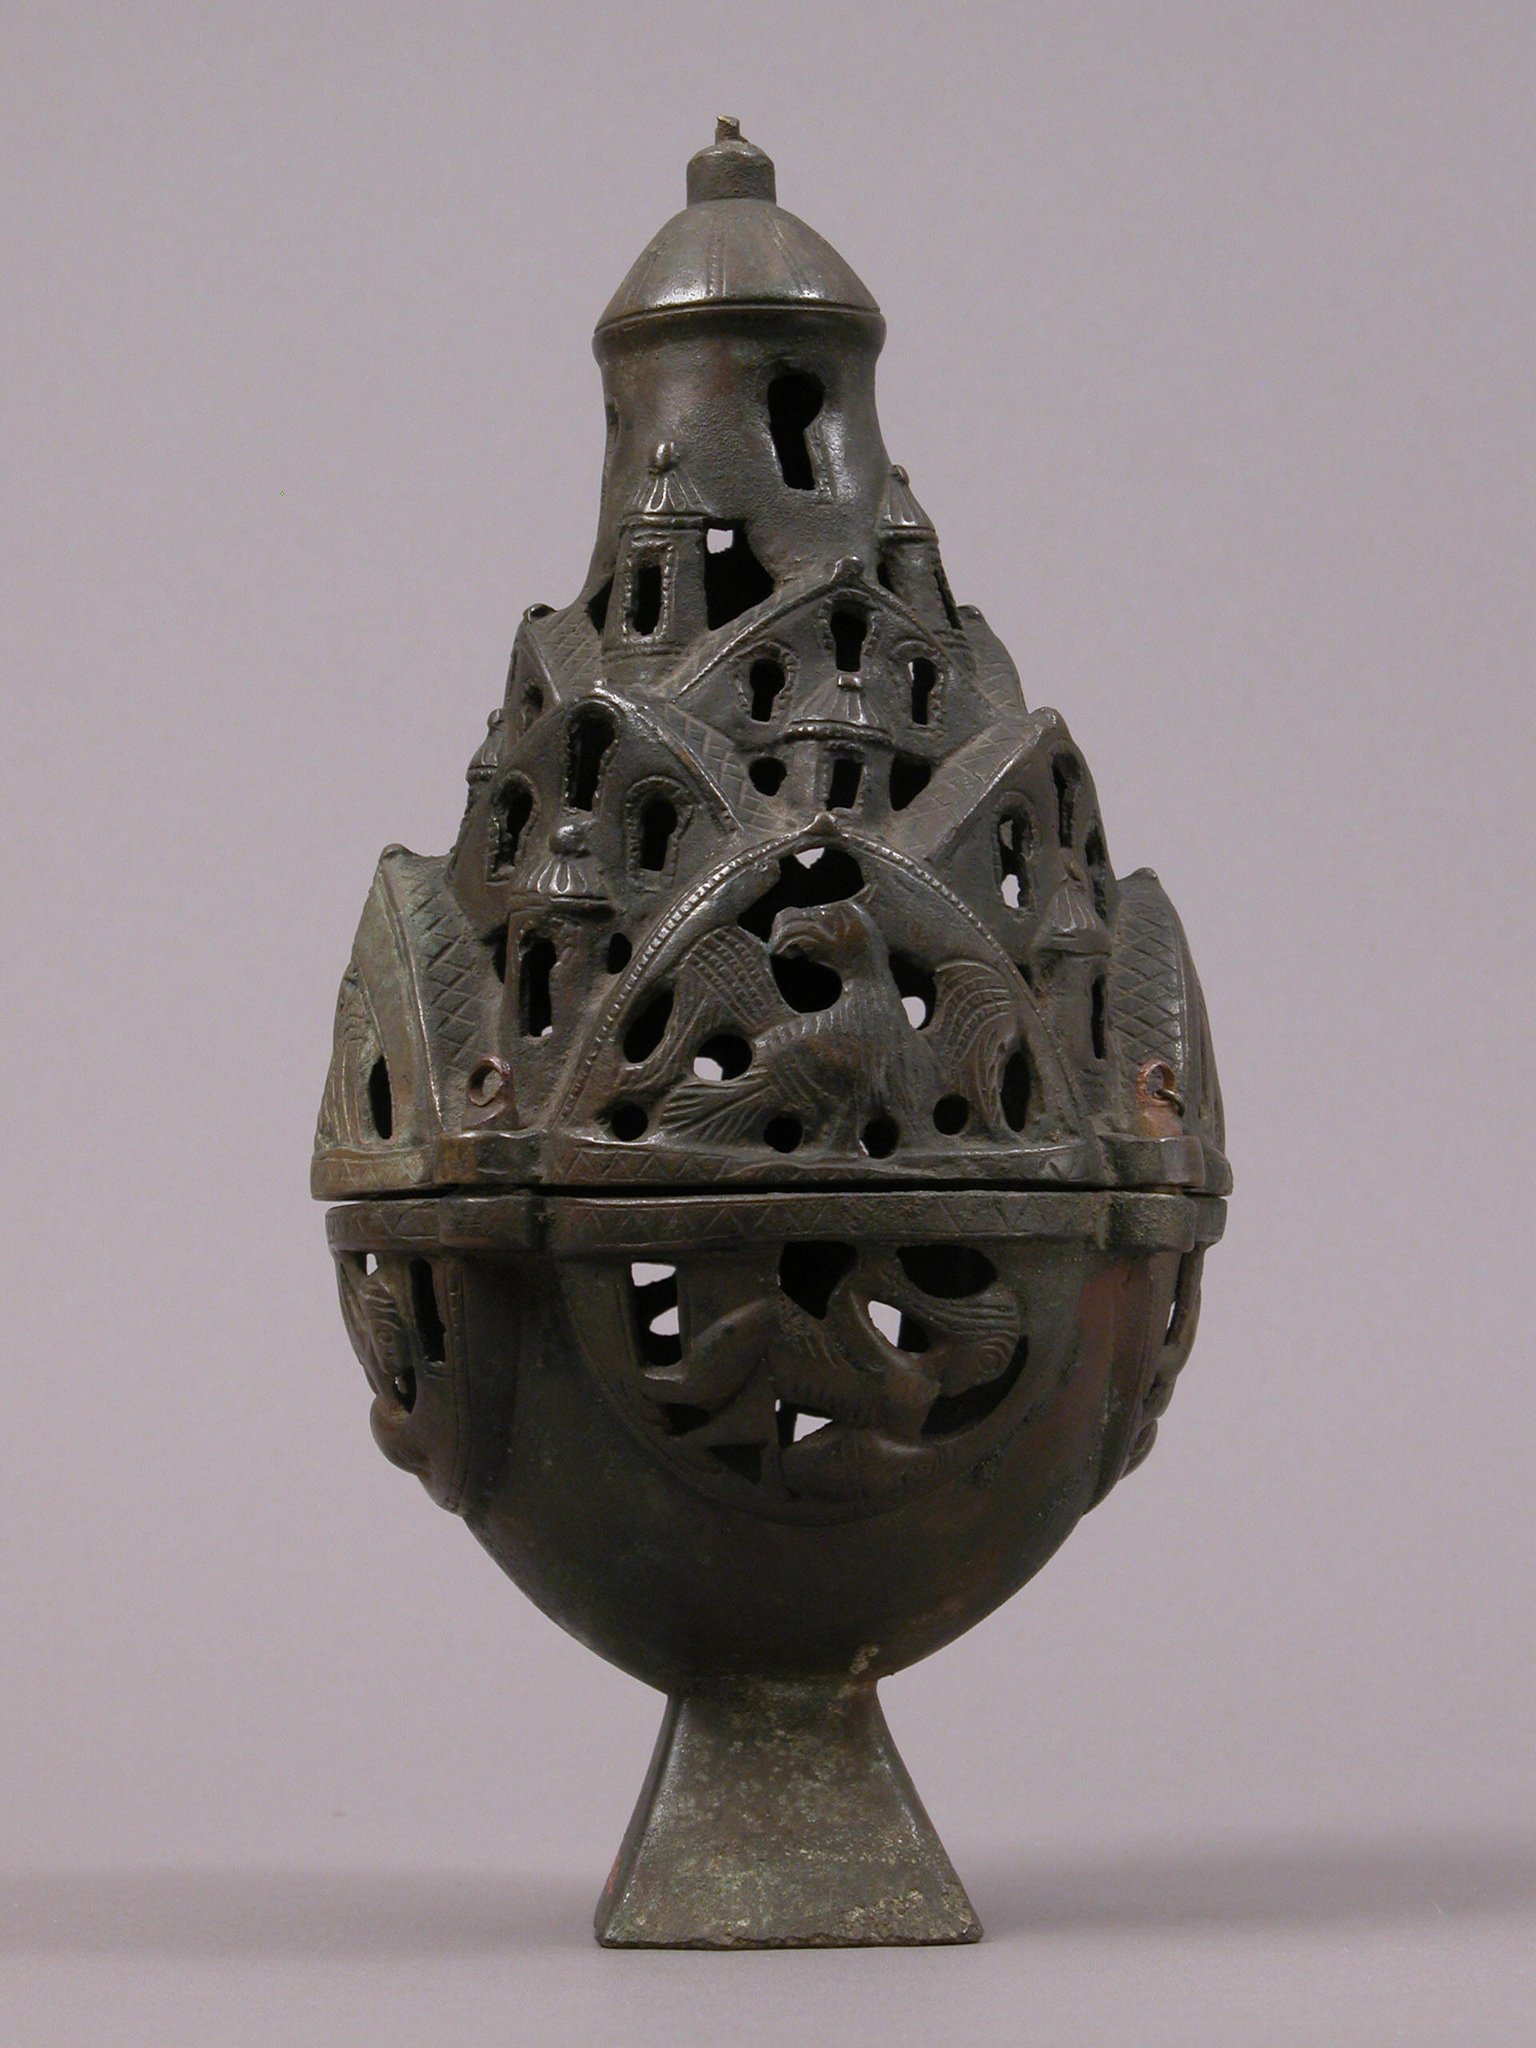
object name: censer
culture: german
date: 1001-1200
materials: copper alloy